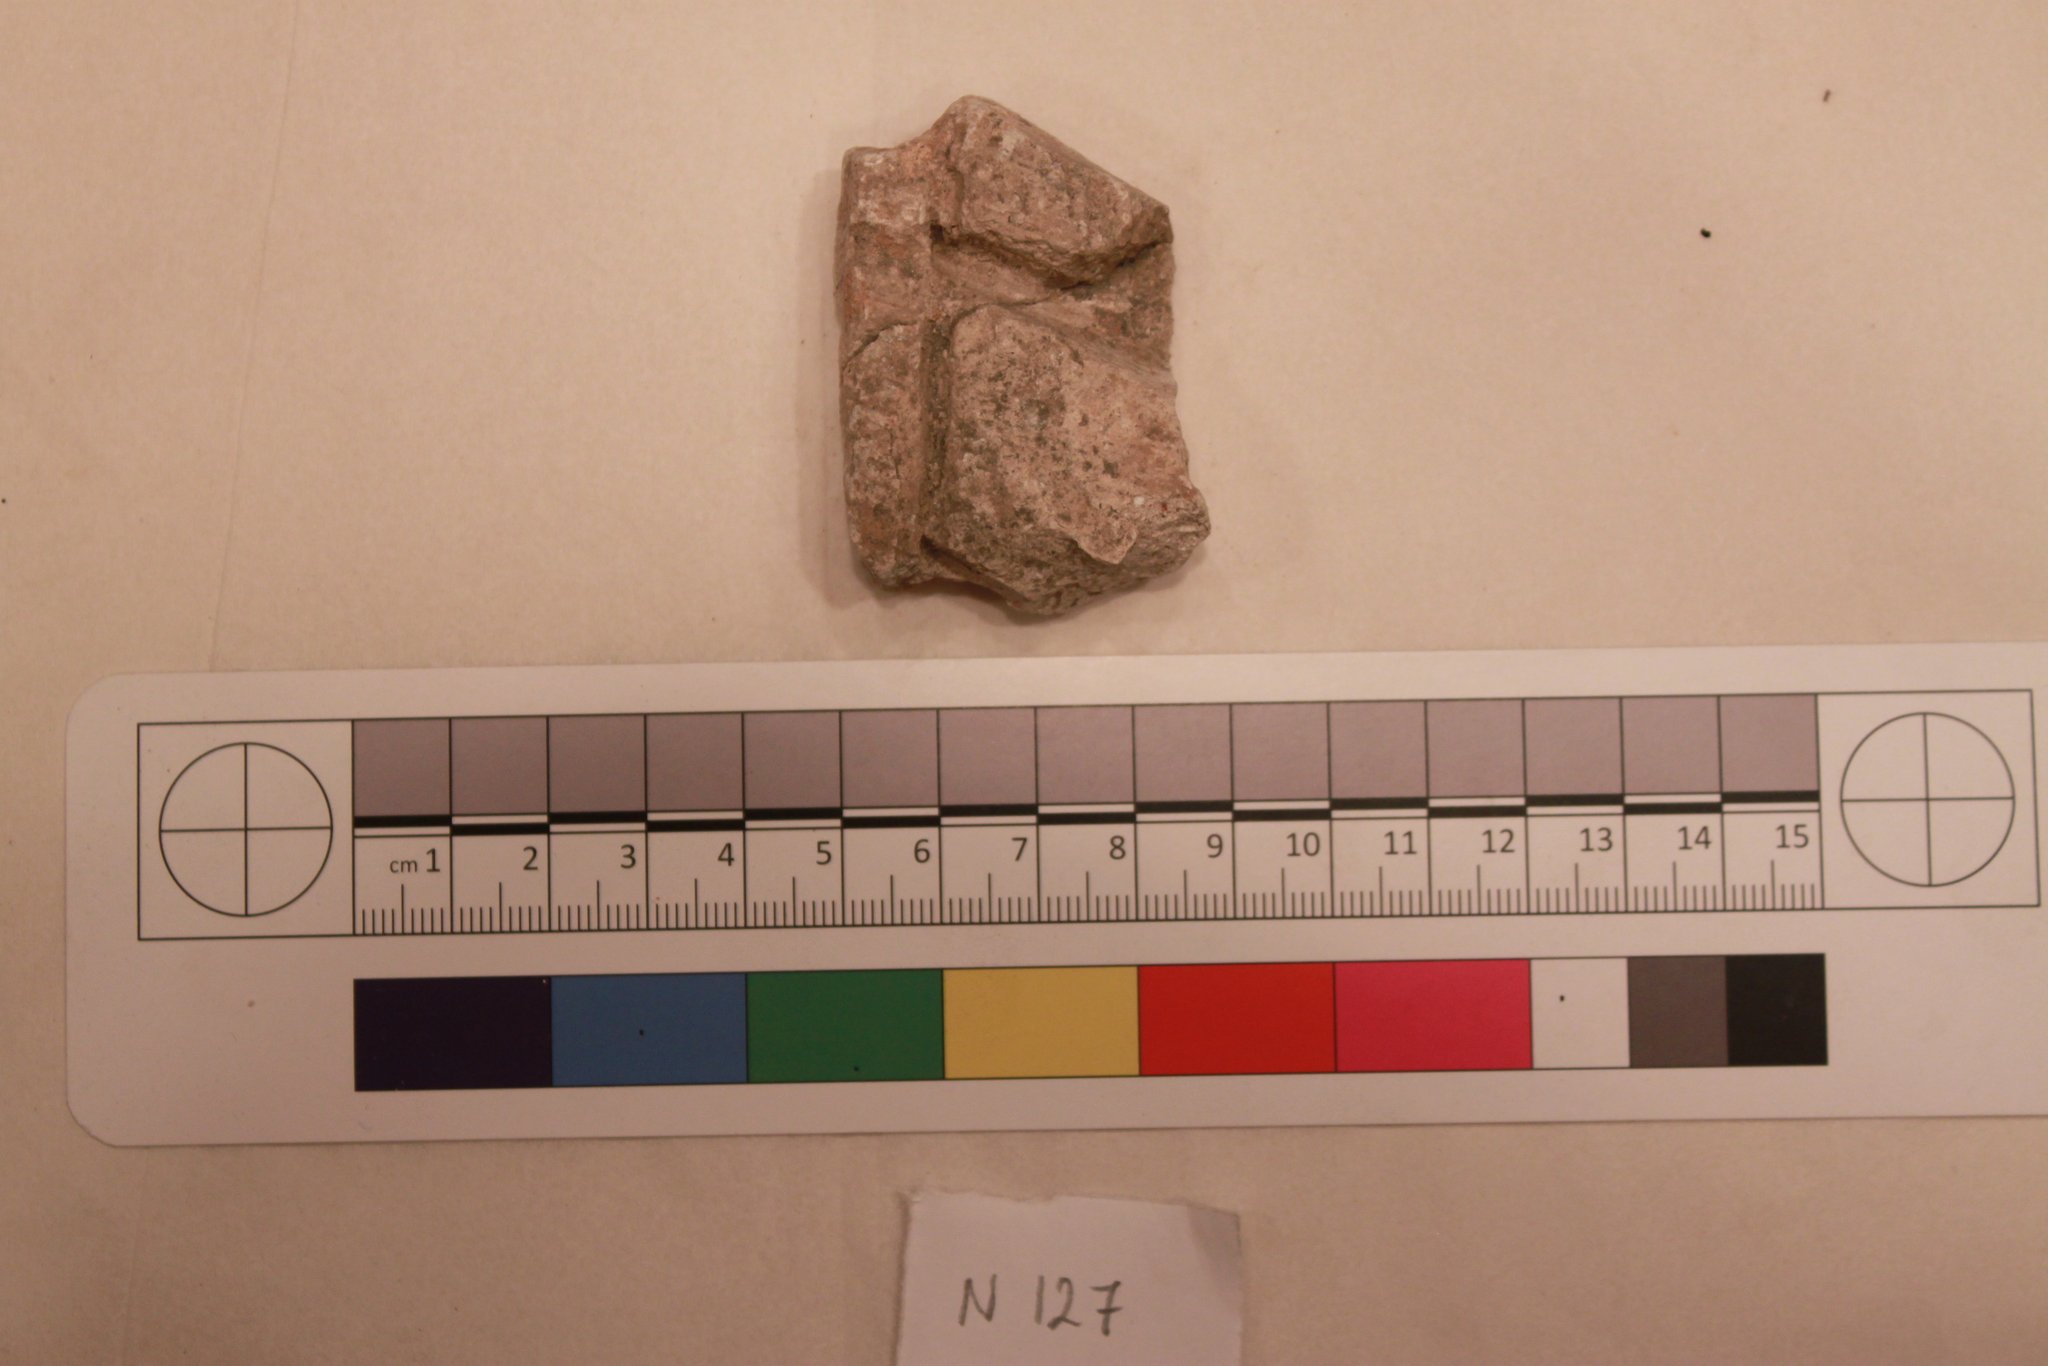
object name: fragment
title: Stucco Fragment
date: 701-1200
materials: plaster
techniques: carving, painting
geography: iran